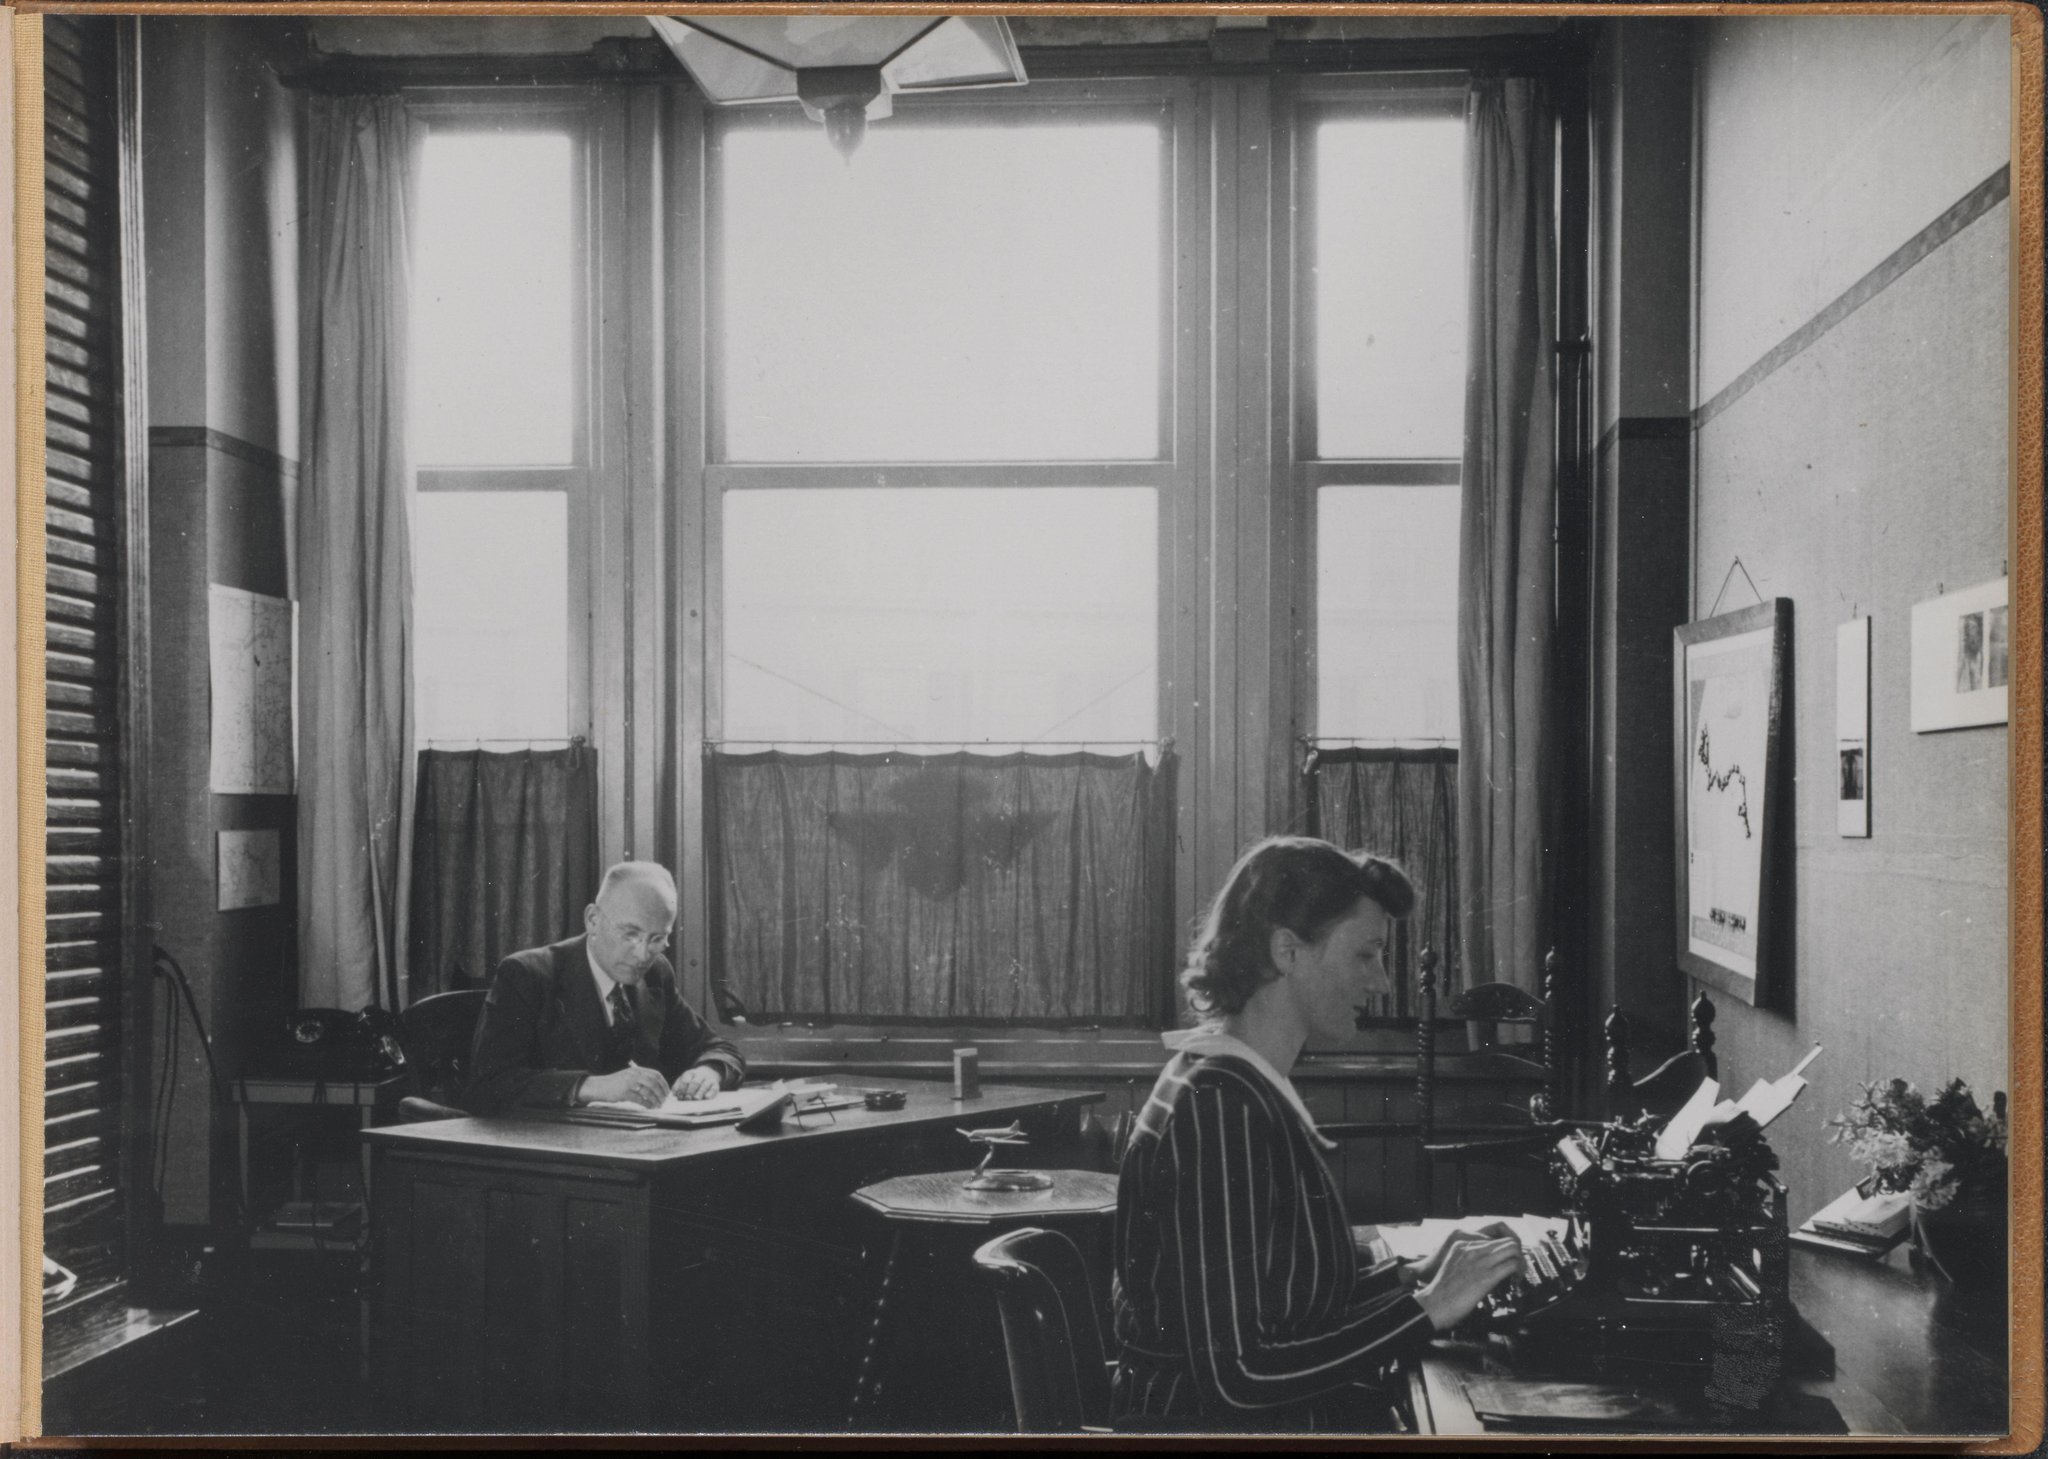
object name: photograph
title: Hans Martin en een vrouw in een werkkamer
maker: Anonymous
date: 1930-1940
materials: cardboard, paper, photographic support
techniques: gelatin silver print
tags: airborne traffic, aviation, typewriter, travelling; tourism, office (~ administration)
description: Albumblad met een foto van Hans Martin, de grondlegger van de Indië-lijn van de KLM, zittend aan een bureau in een werkkamer samen met een typiste. Onderdeel van Herdenkingsalbum van de Indië-lijn van de KLM, deel II.